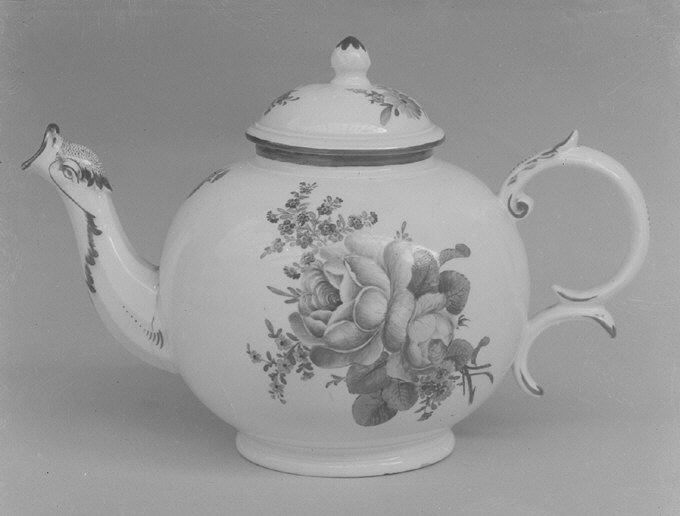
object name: teapot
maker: fulda pottery and porcelain manufactory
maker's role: manufactory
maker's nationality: german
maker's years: 1764-1789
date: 1781-1788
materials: hard paste porcelain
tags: flowers